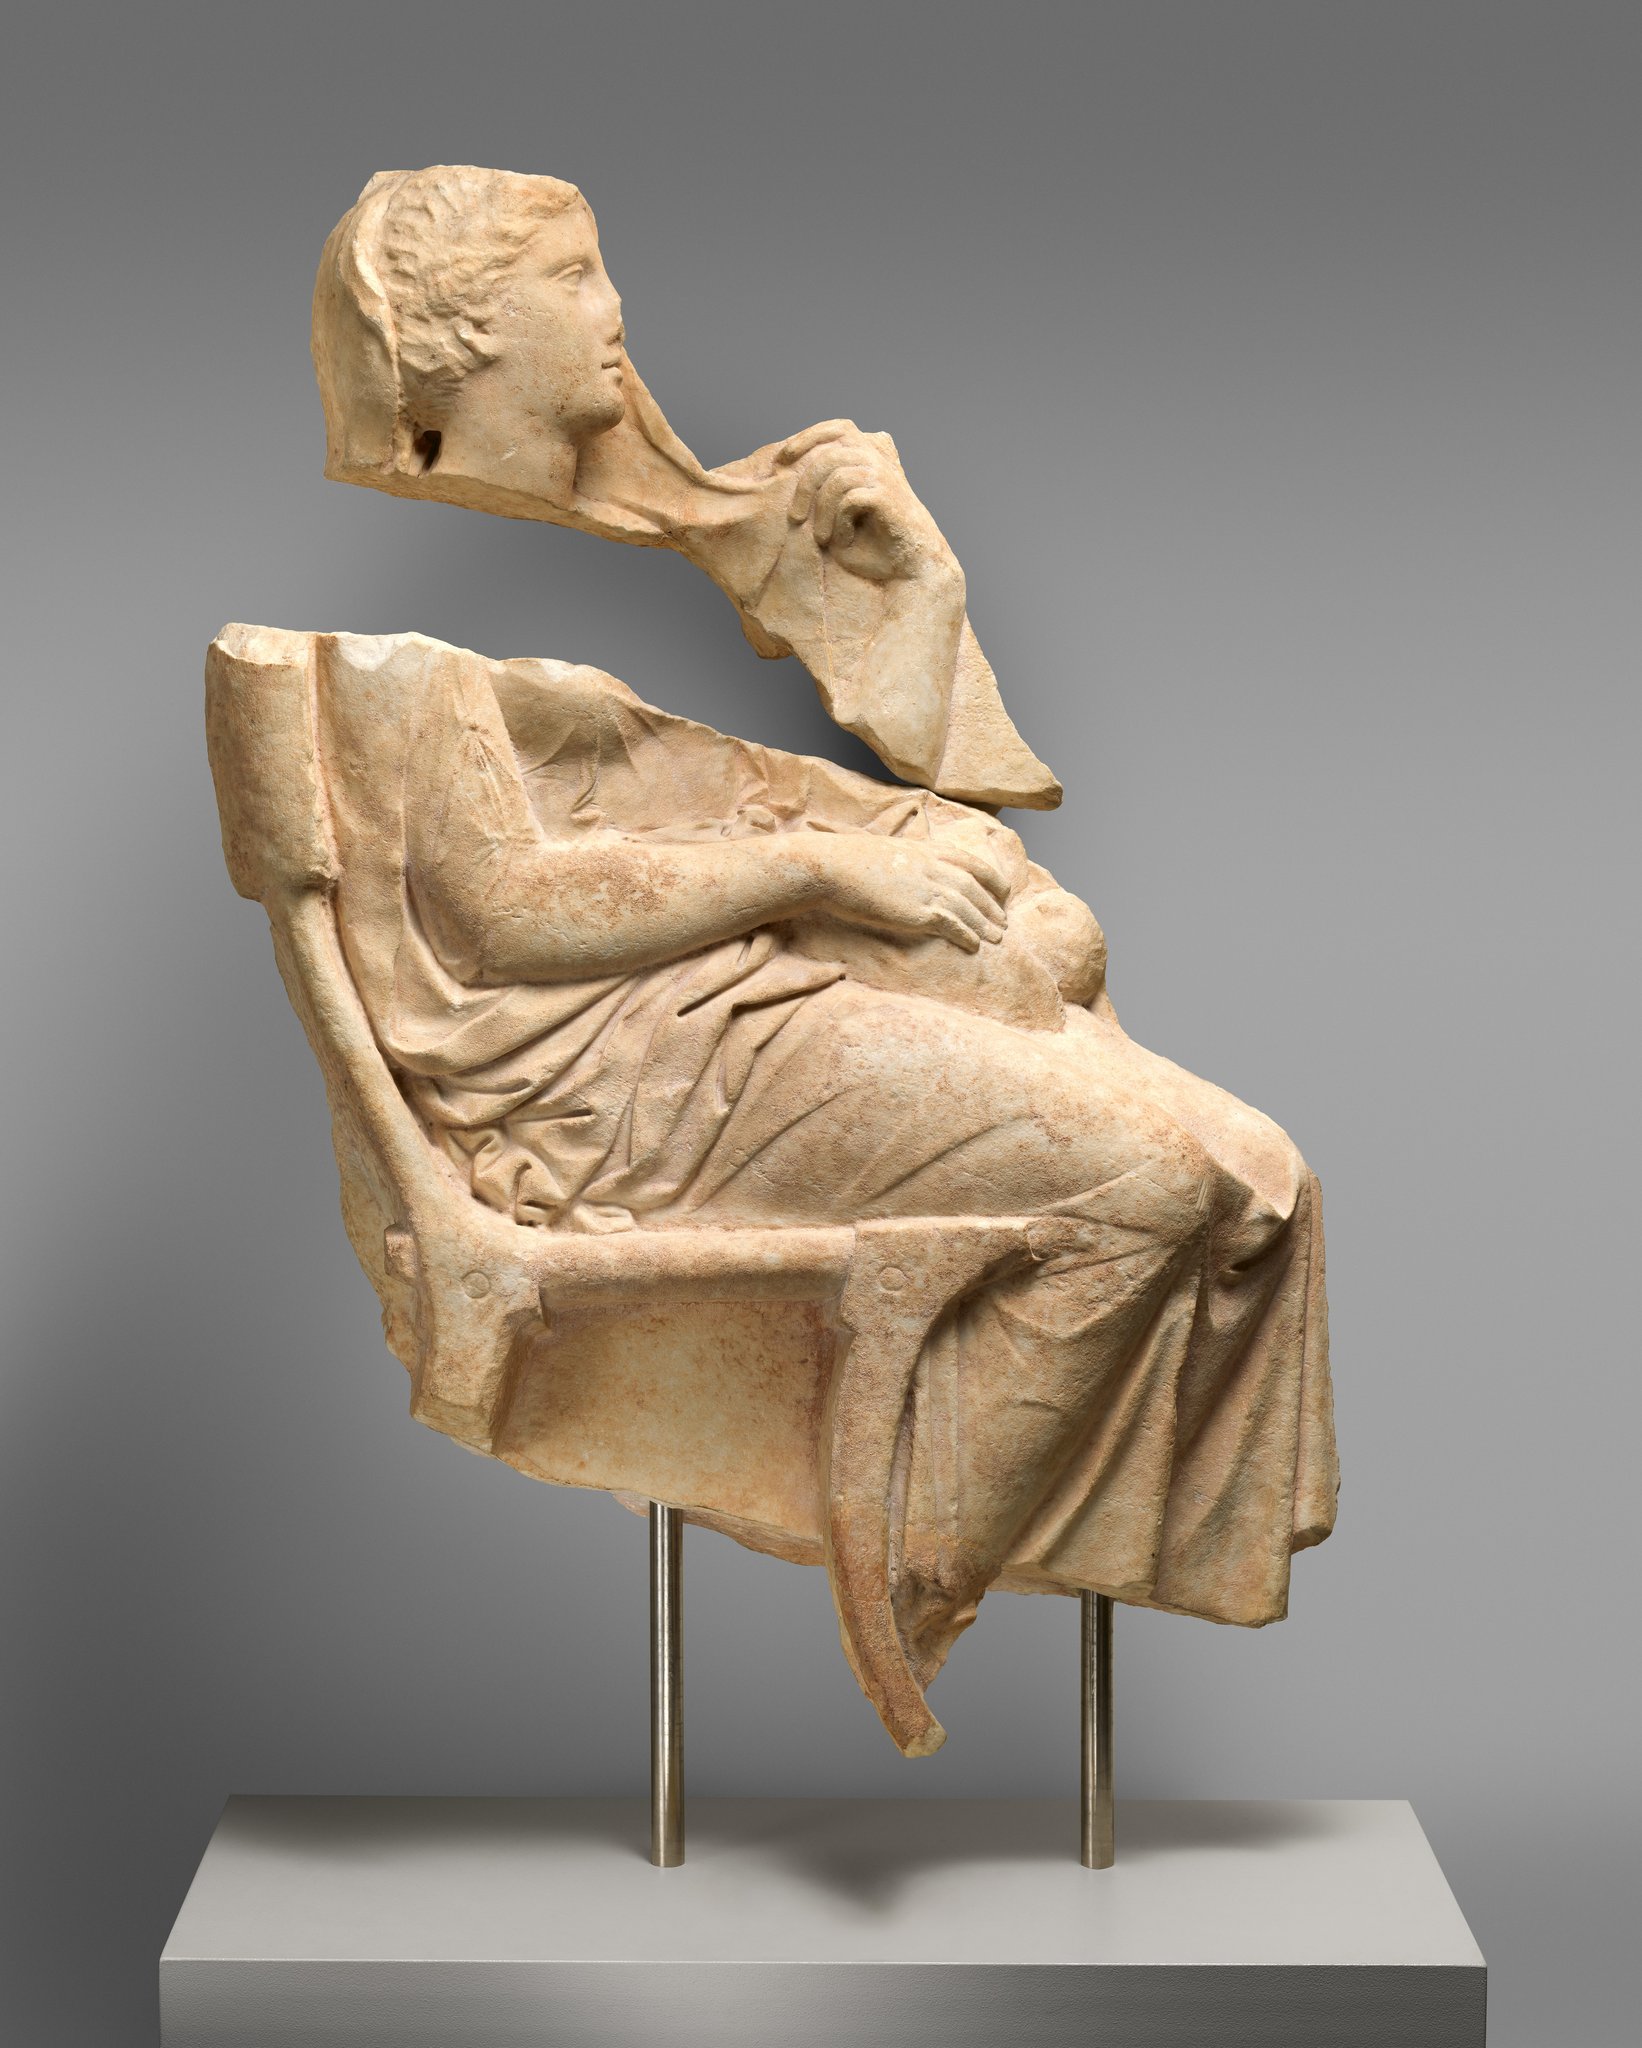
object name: grave stele of a woman holding a baby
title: Fragments of the marble stele (grave marker) of a woman holding a baby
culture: greek, attic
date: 400-375 BCE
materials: marble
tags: infants,women